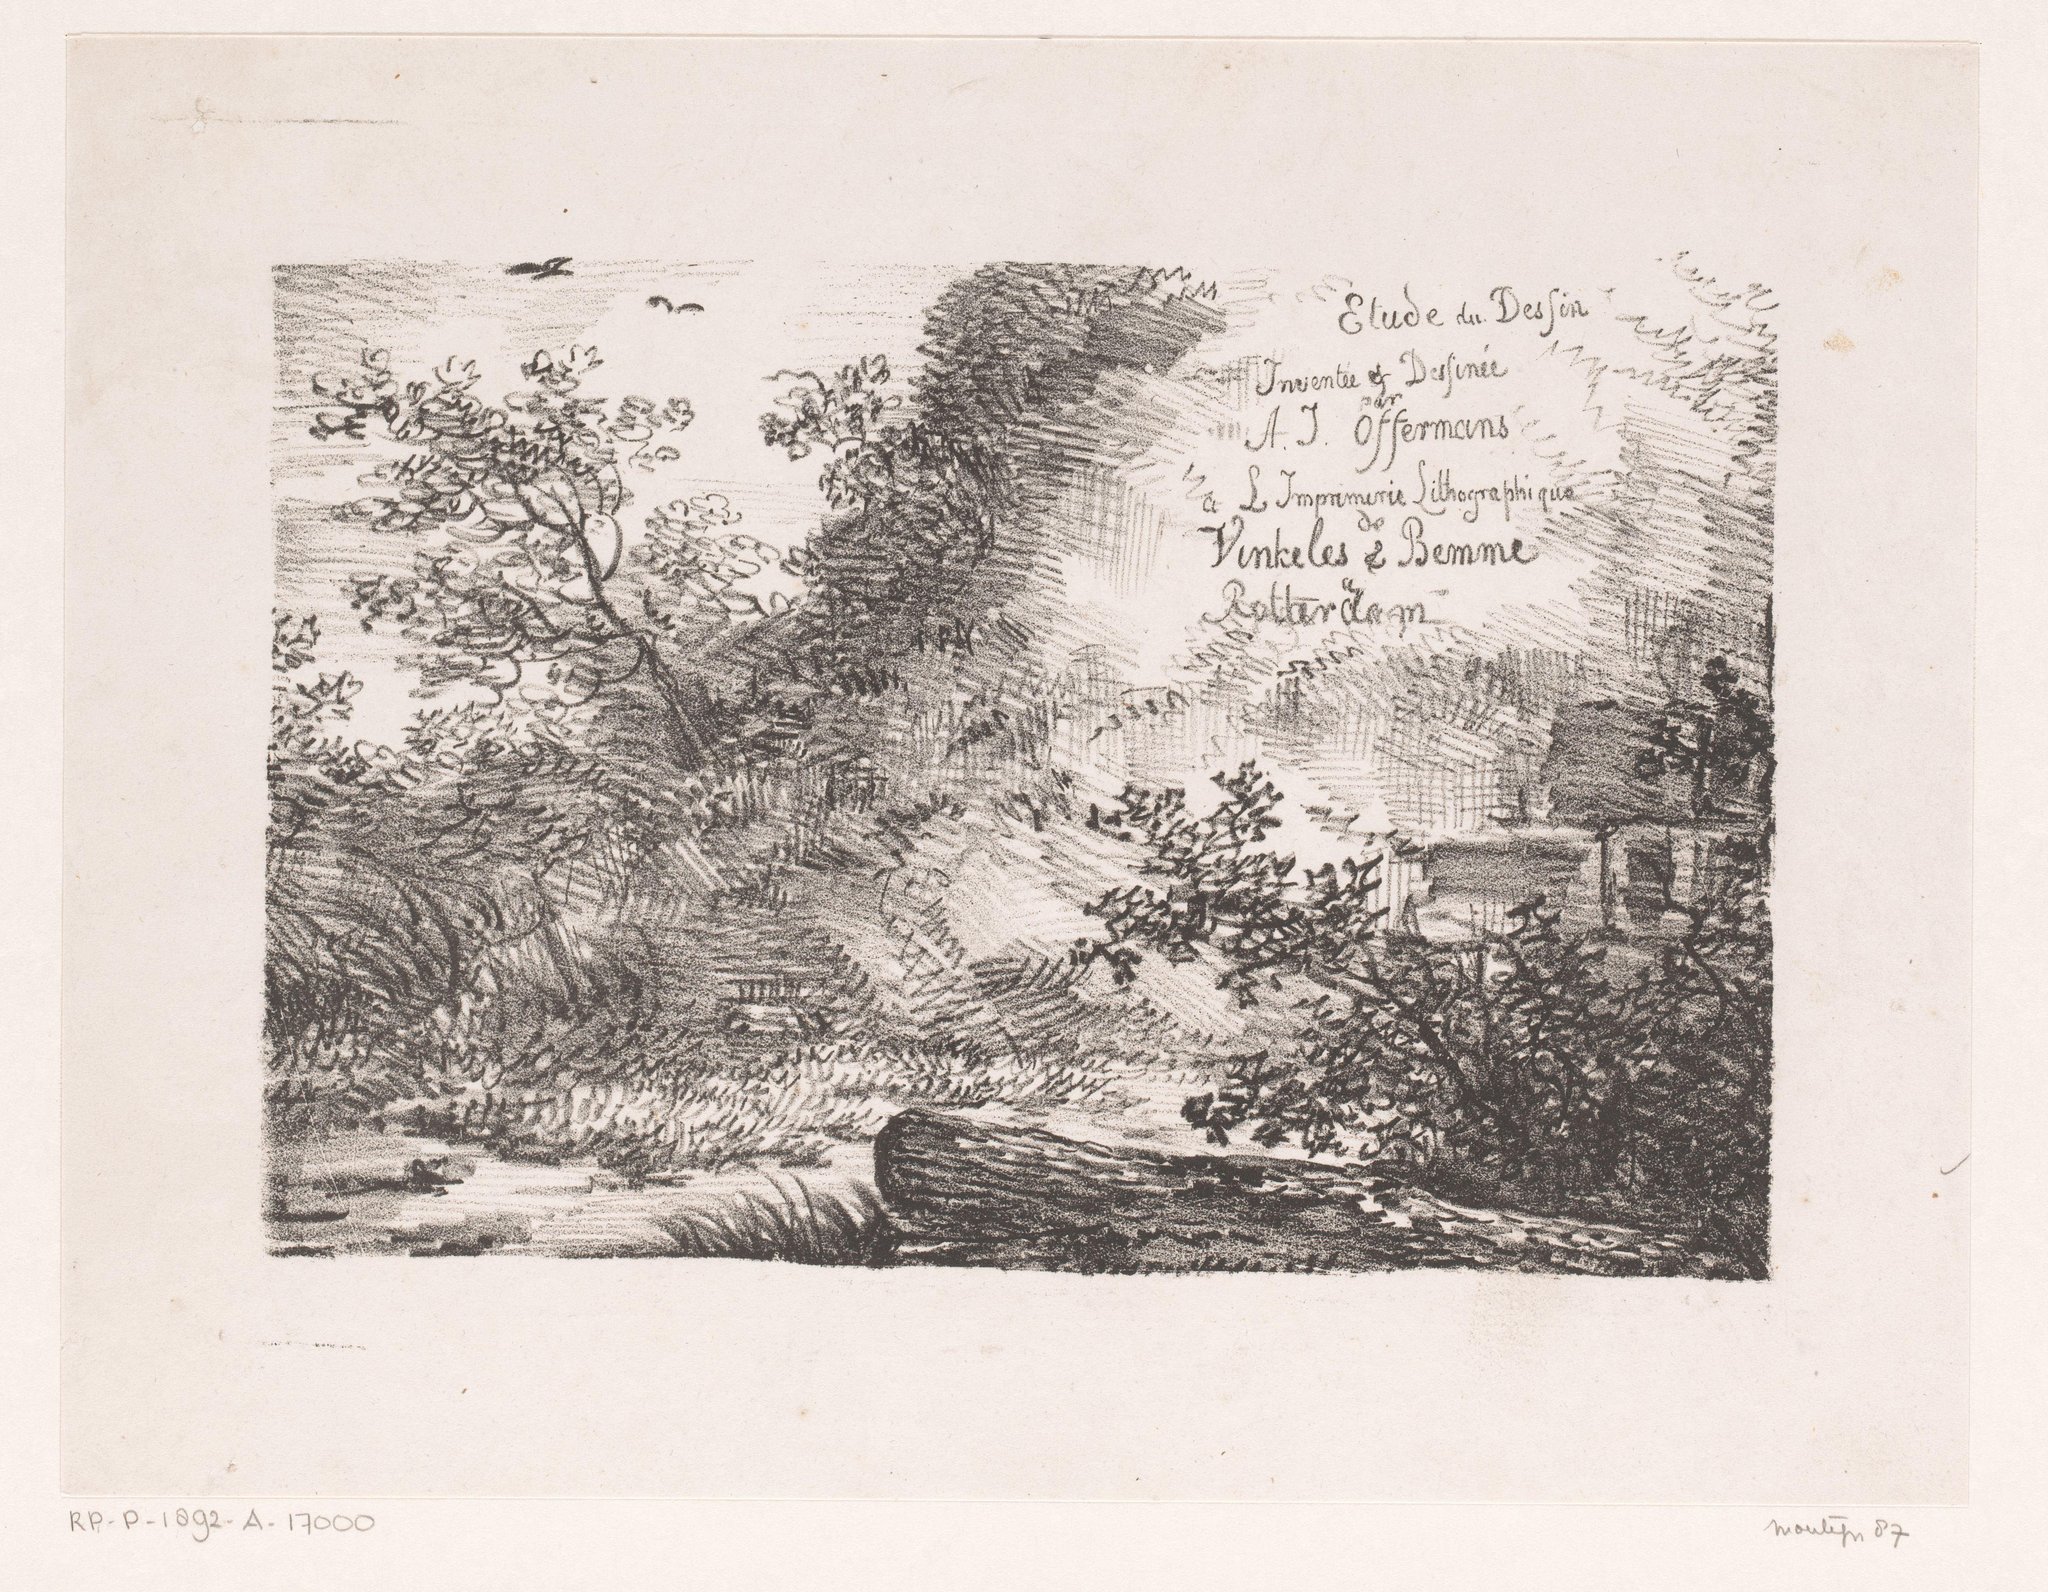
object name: print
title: Kreupelhout en struiken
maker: anthony jacobus offermans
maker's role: draughtsman, print maker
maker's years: 1796-1872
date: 1825-1829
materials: paper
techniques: lithograph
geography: rotterdam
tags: bush, shrubs ~ forest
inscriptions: collector's mark: Lugt 2228